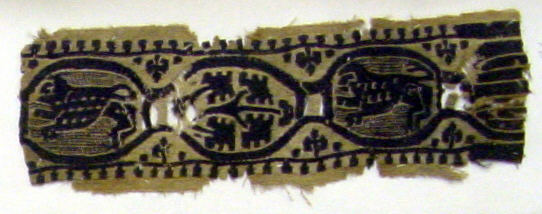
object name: textile fragment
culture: coptic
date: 501-600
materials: linen, wool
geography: egypt